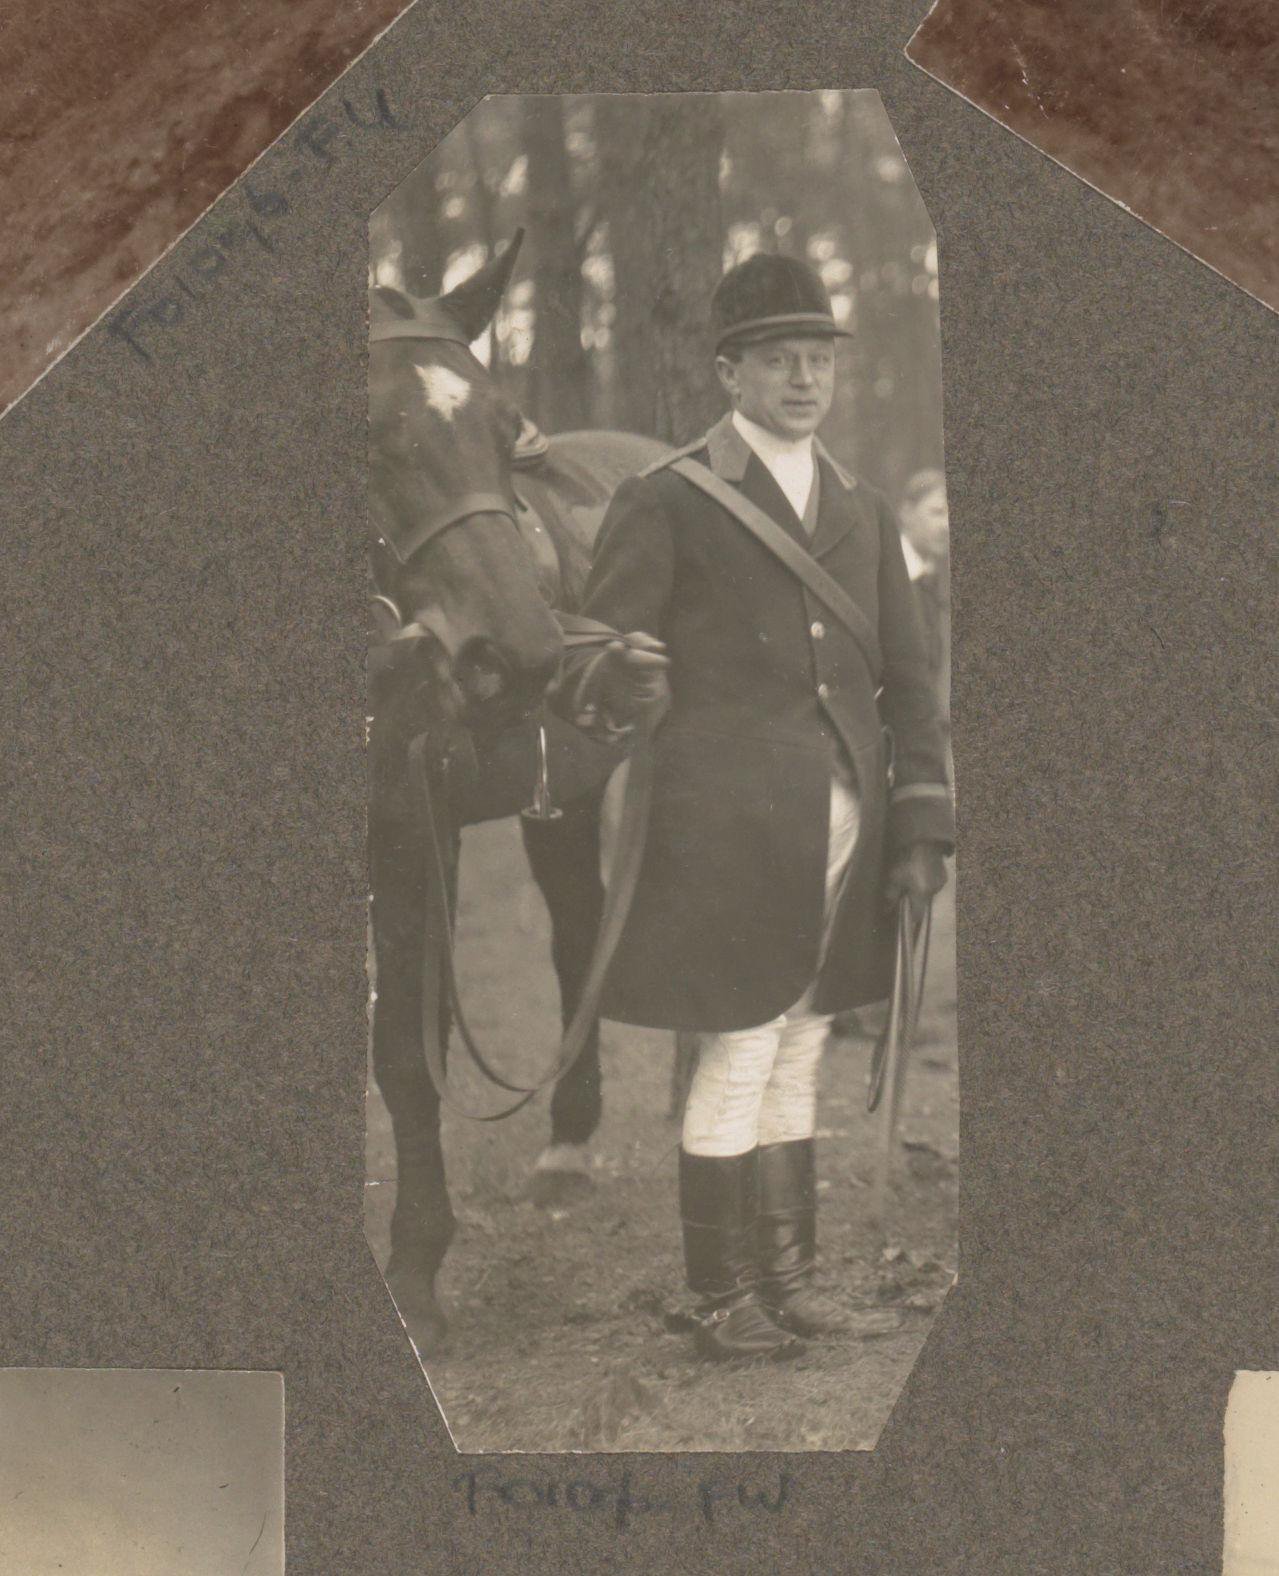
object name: album leaf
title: Ruitertafereel op Koninklijke Houtvesterij Het Loo: ruiter staand naast een paard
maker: Anonymous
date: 1900-1925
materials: photographic support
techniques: gelatin silver print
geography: het loo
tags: riding a horse, ass, or mule; rider, horseman, hunting, chase, hunting-ground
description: Onderdeel van Fotoalbum van de heer Brams, opperhoutvester van koningin Wilhelmina op Koninklijke Houtvesterij Het Loo.